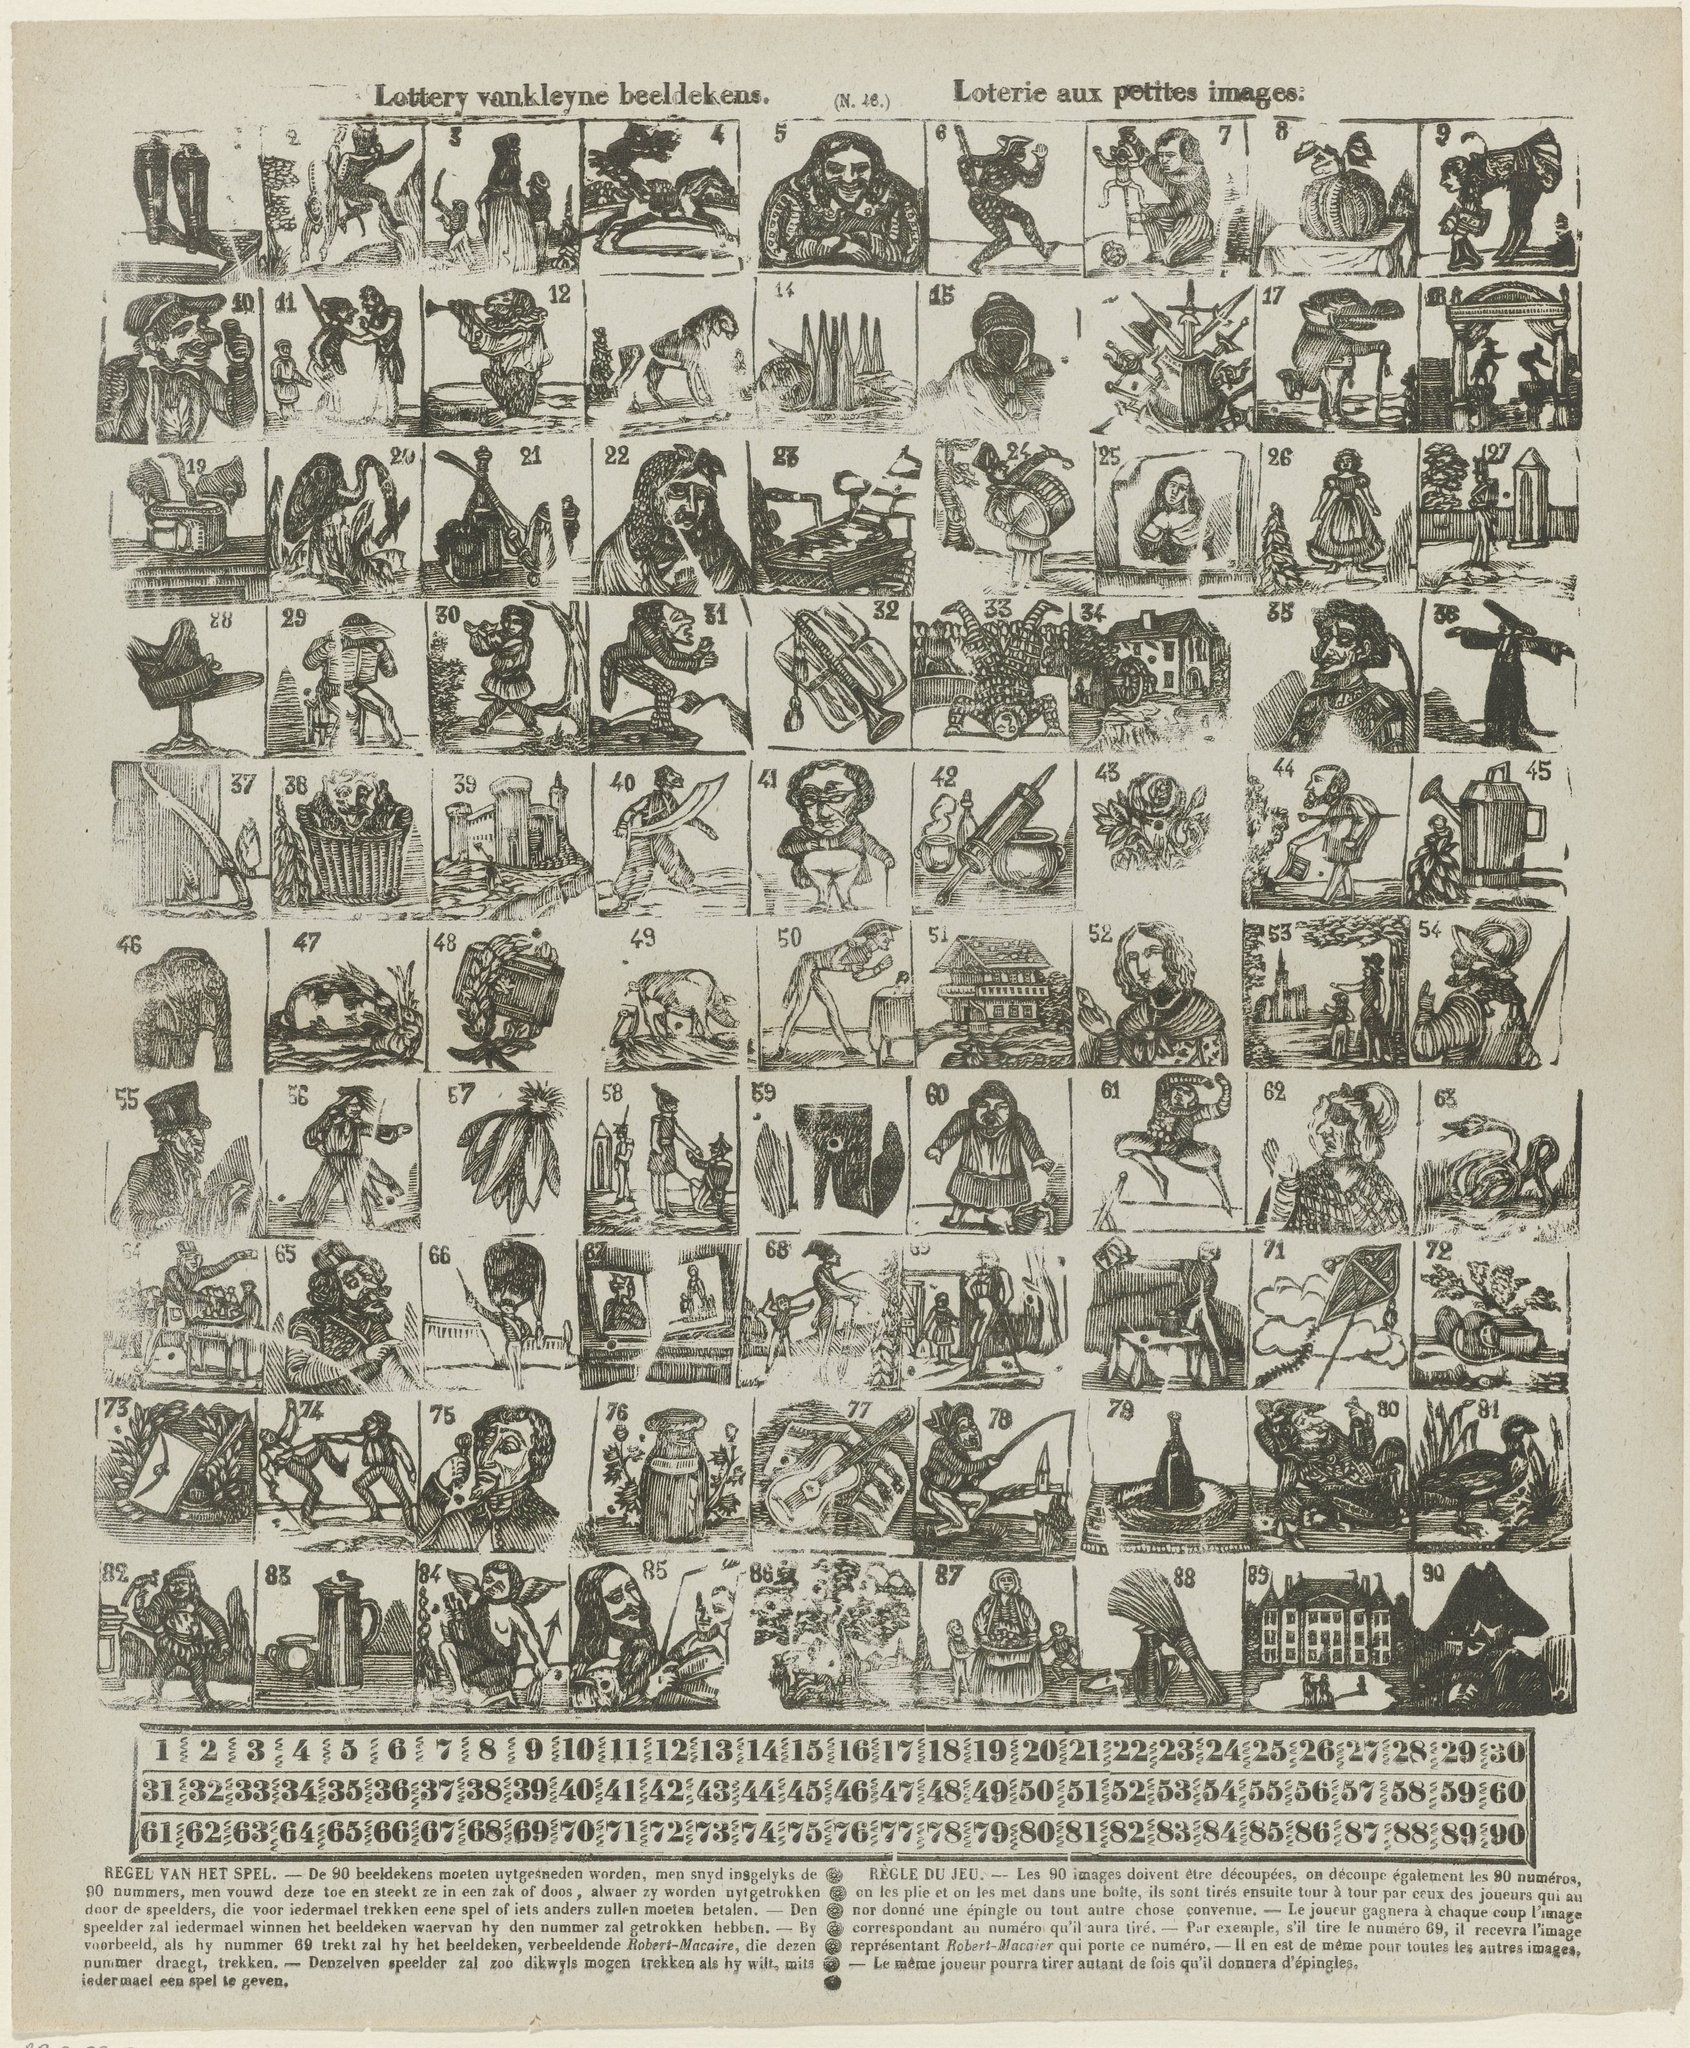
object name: popular print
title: Lottery van kleyne beeldekens / Loterie aux petites images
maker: Anonymous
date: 1856-1900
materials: paper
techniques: letterpress printing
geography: turnhout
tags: animals, characters (human types), group games, party games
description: Loterijspel. Blad met 90 genummerde voorstellingen van figuren, dieren en voorwerpen om uit te knippen. In de ondermarge de spelregels in het Nederlands en in het Frans in twee kolommen. Genummerd midden boven: (N. 46.).